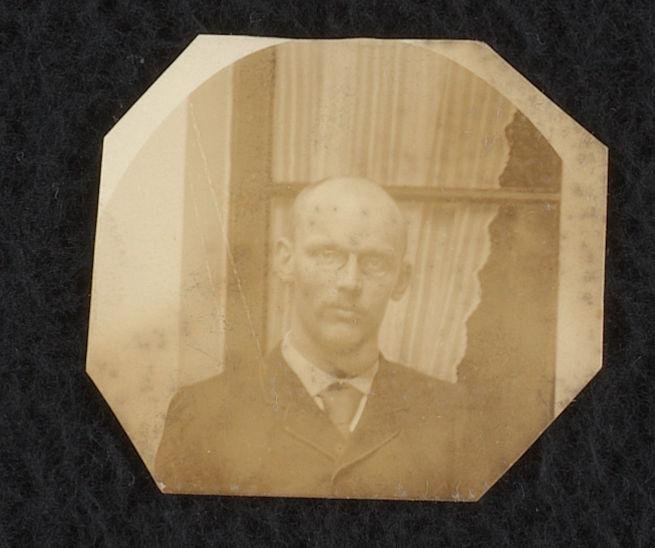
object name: photograph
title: Portret van Herman Gorter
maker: Anonymous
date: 1900-1920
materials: photographic support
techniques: albumen print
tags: herman gorter, adult woman, historical persons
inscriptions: annotation: ‘Gorter/ vriend van Jonker-familie’